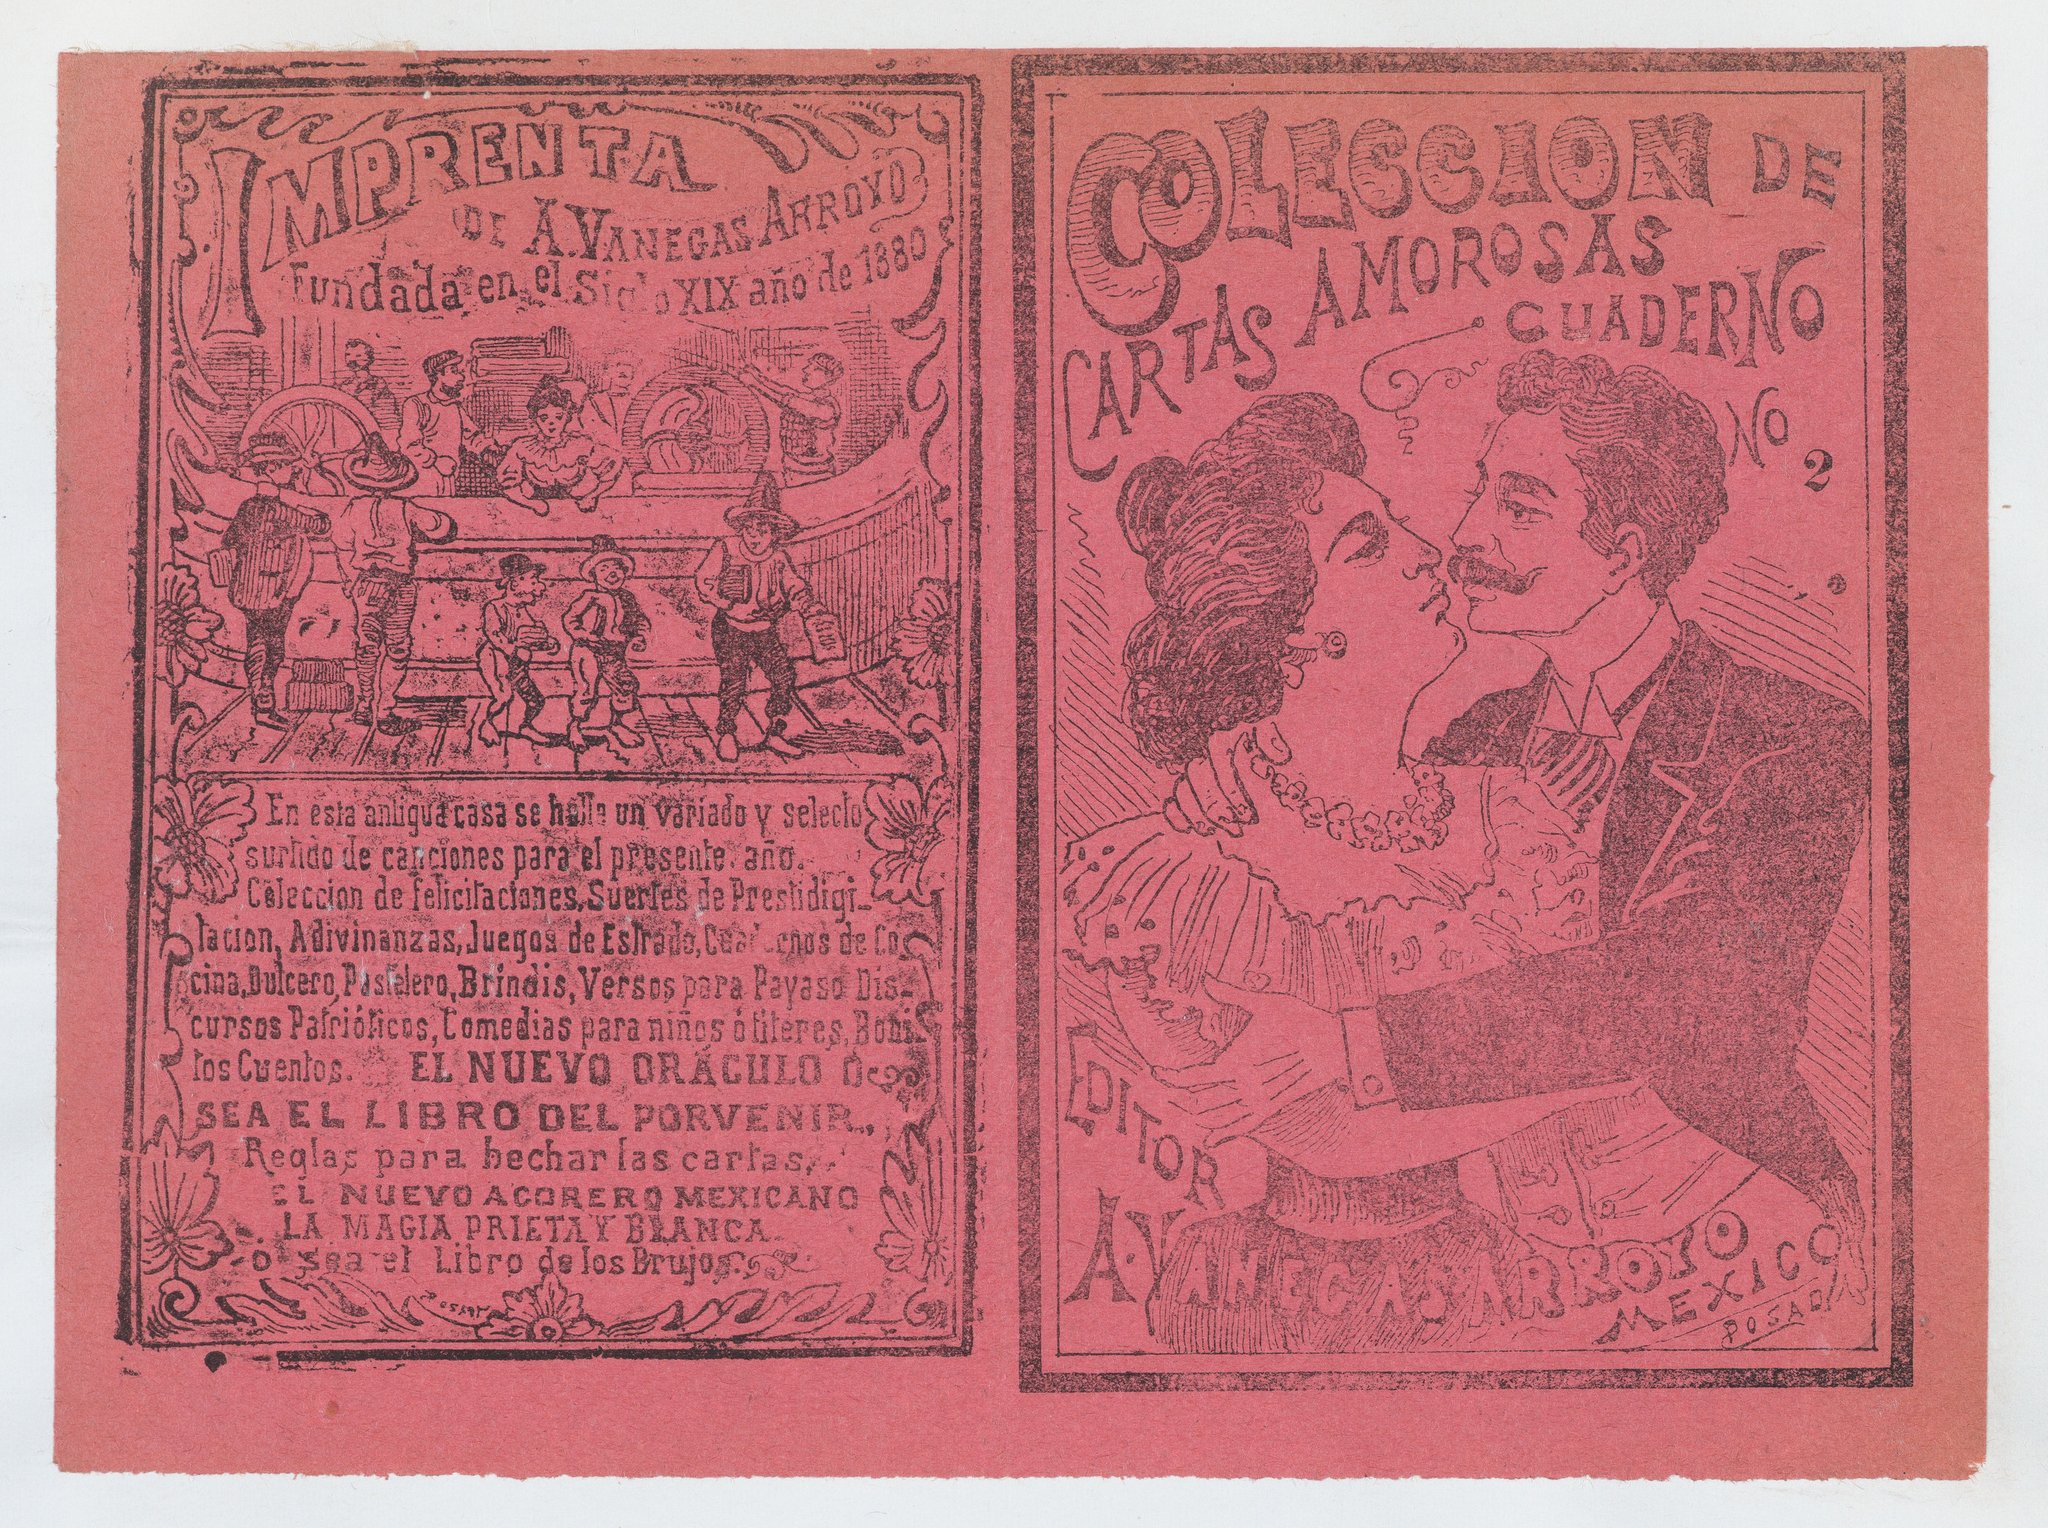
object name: print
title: Cover for 'Coleccion de Cartas Amorosas Cuaderno No. 2', a couple embracing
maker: josé guadalupe posada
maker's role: artist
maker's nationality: mexican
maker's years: 1852-1913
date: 1900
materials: paper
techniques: letterpress, lithography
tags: couples,men,women